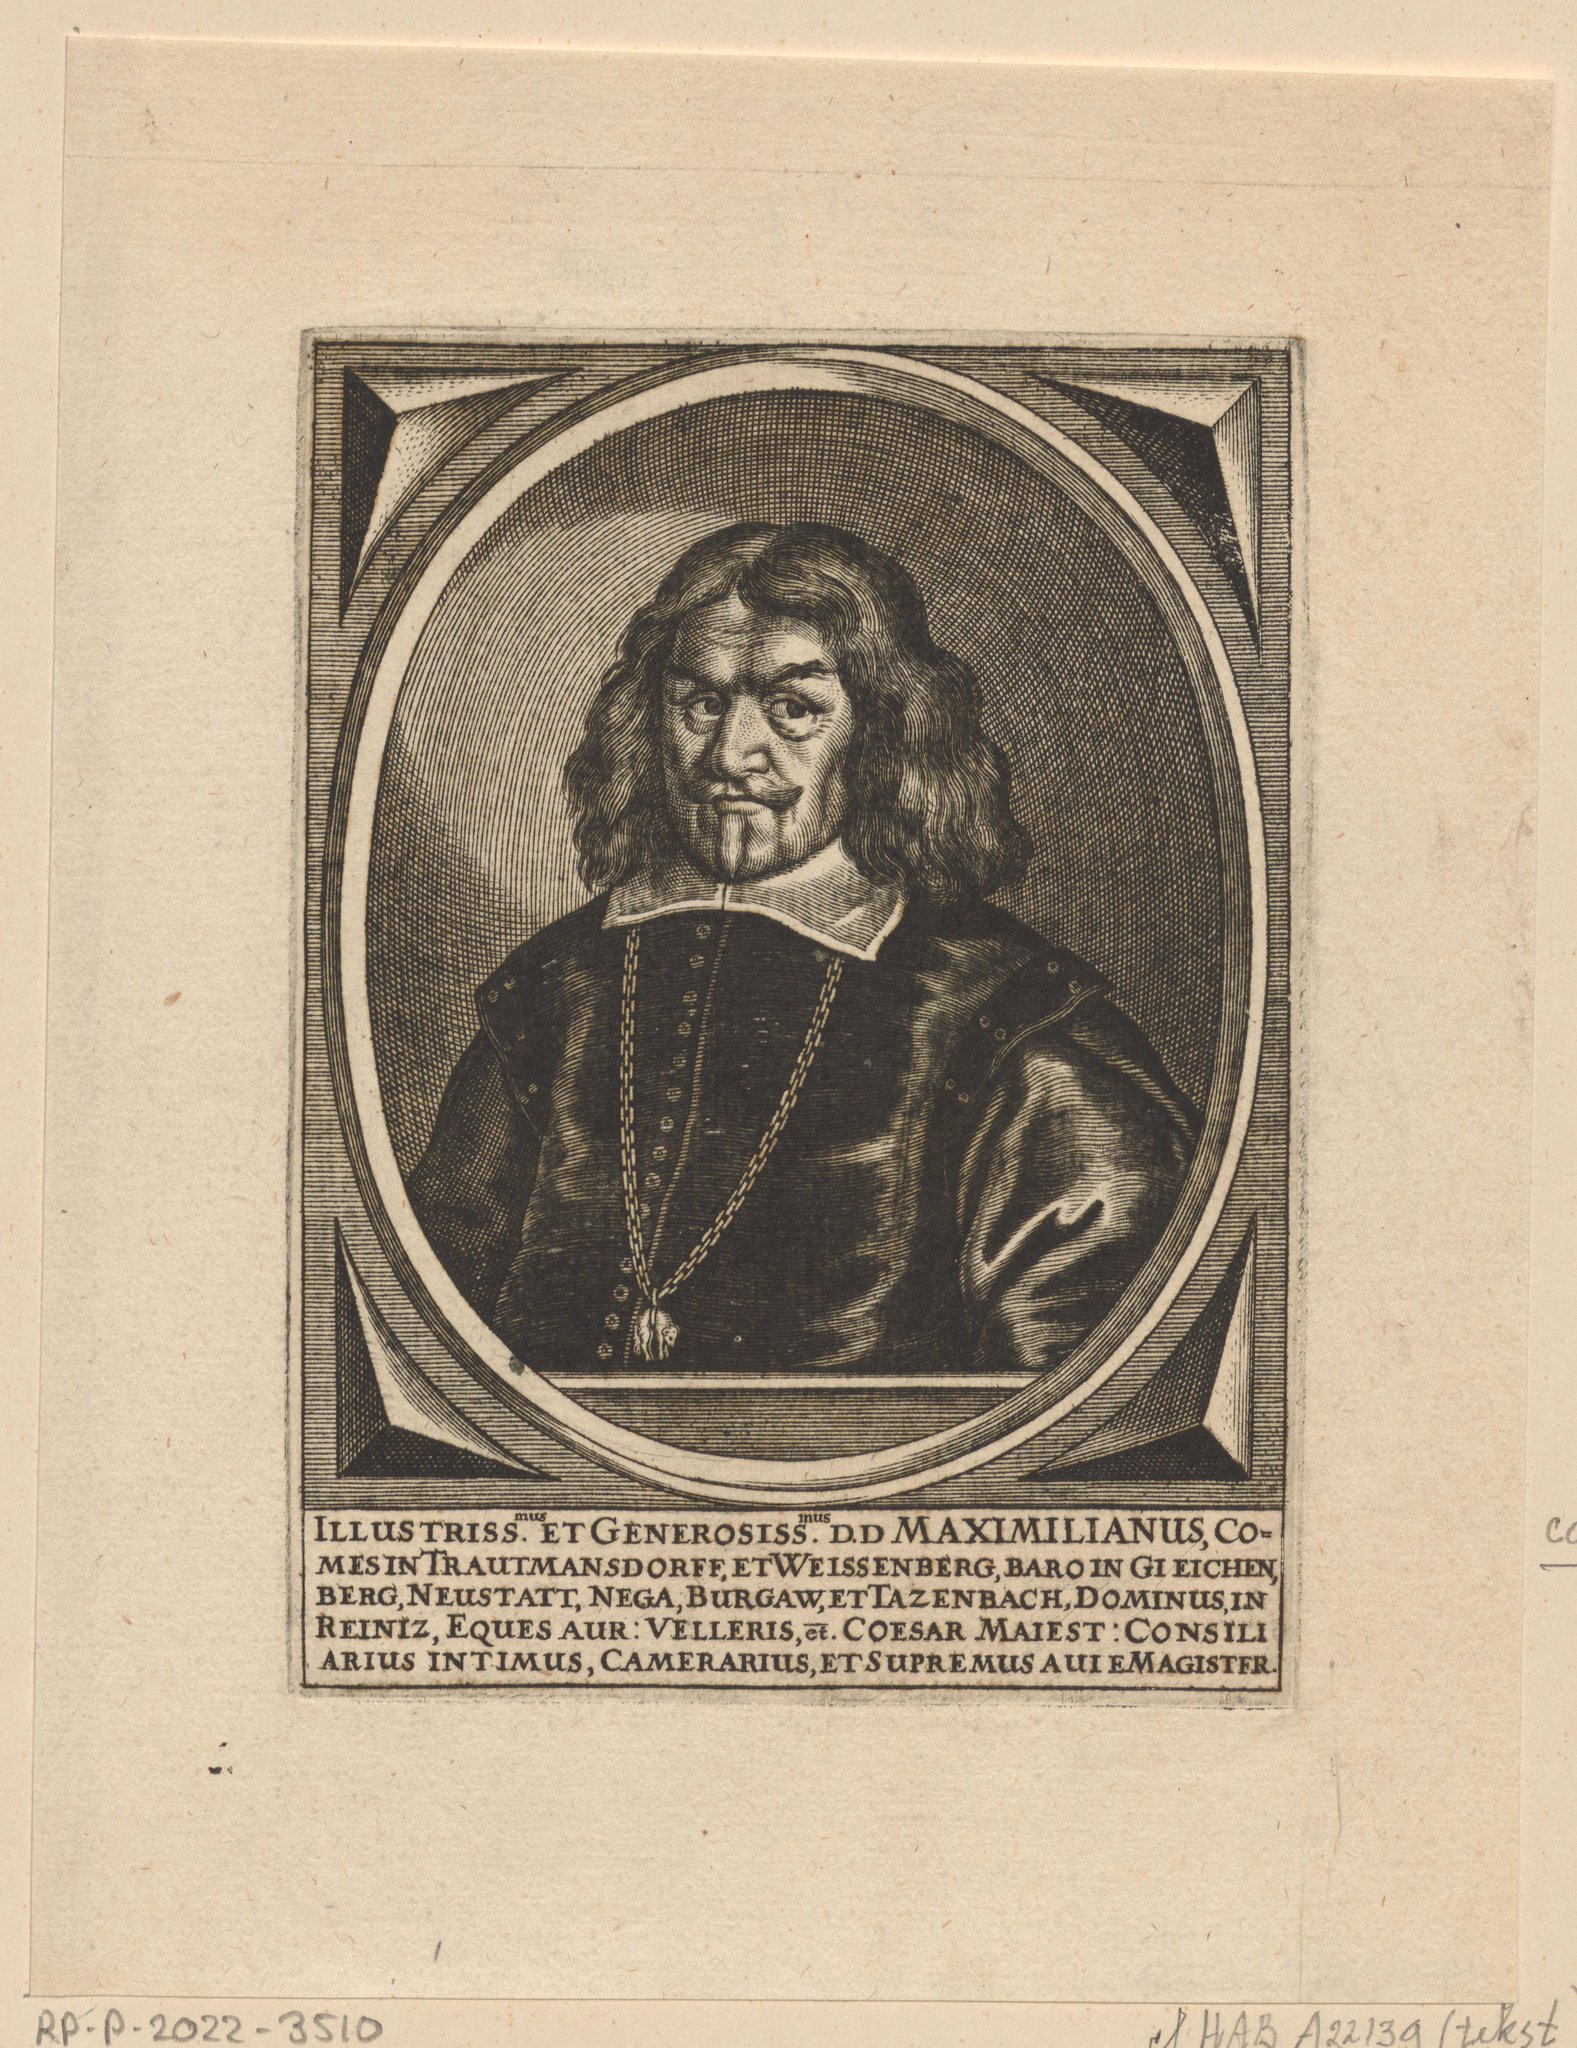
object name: print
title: Portret van Maximilian von Trauttmannsdorf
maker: Anonymous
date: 1647-1749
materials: paper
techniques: engraving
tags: vienna, historical persons, knighthood order of the golden fleece, diplomacy, diplomat